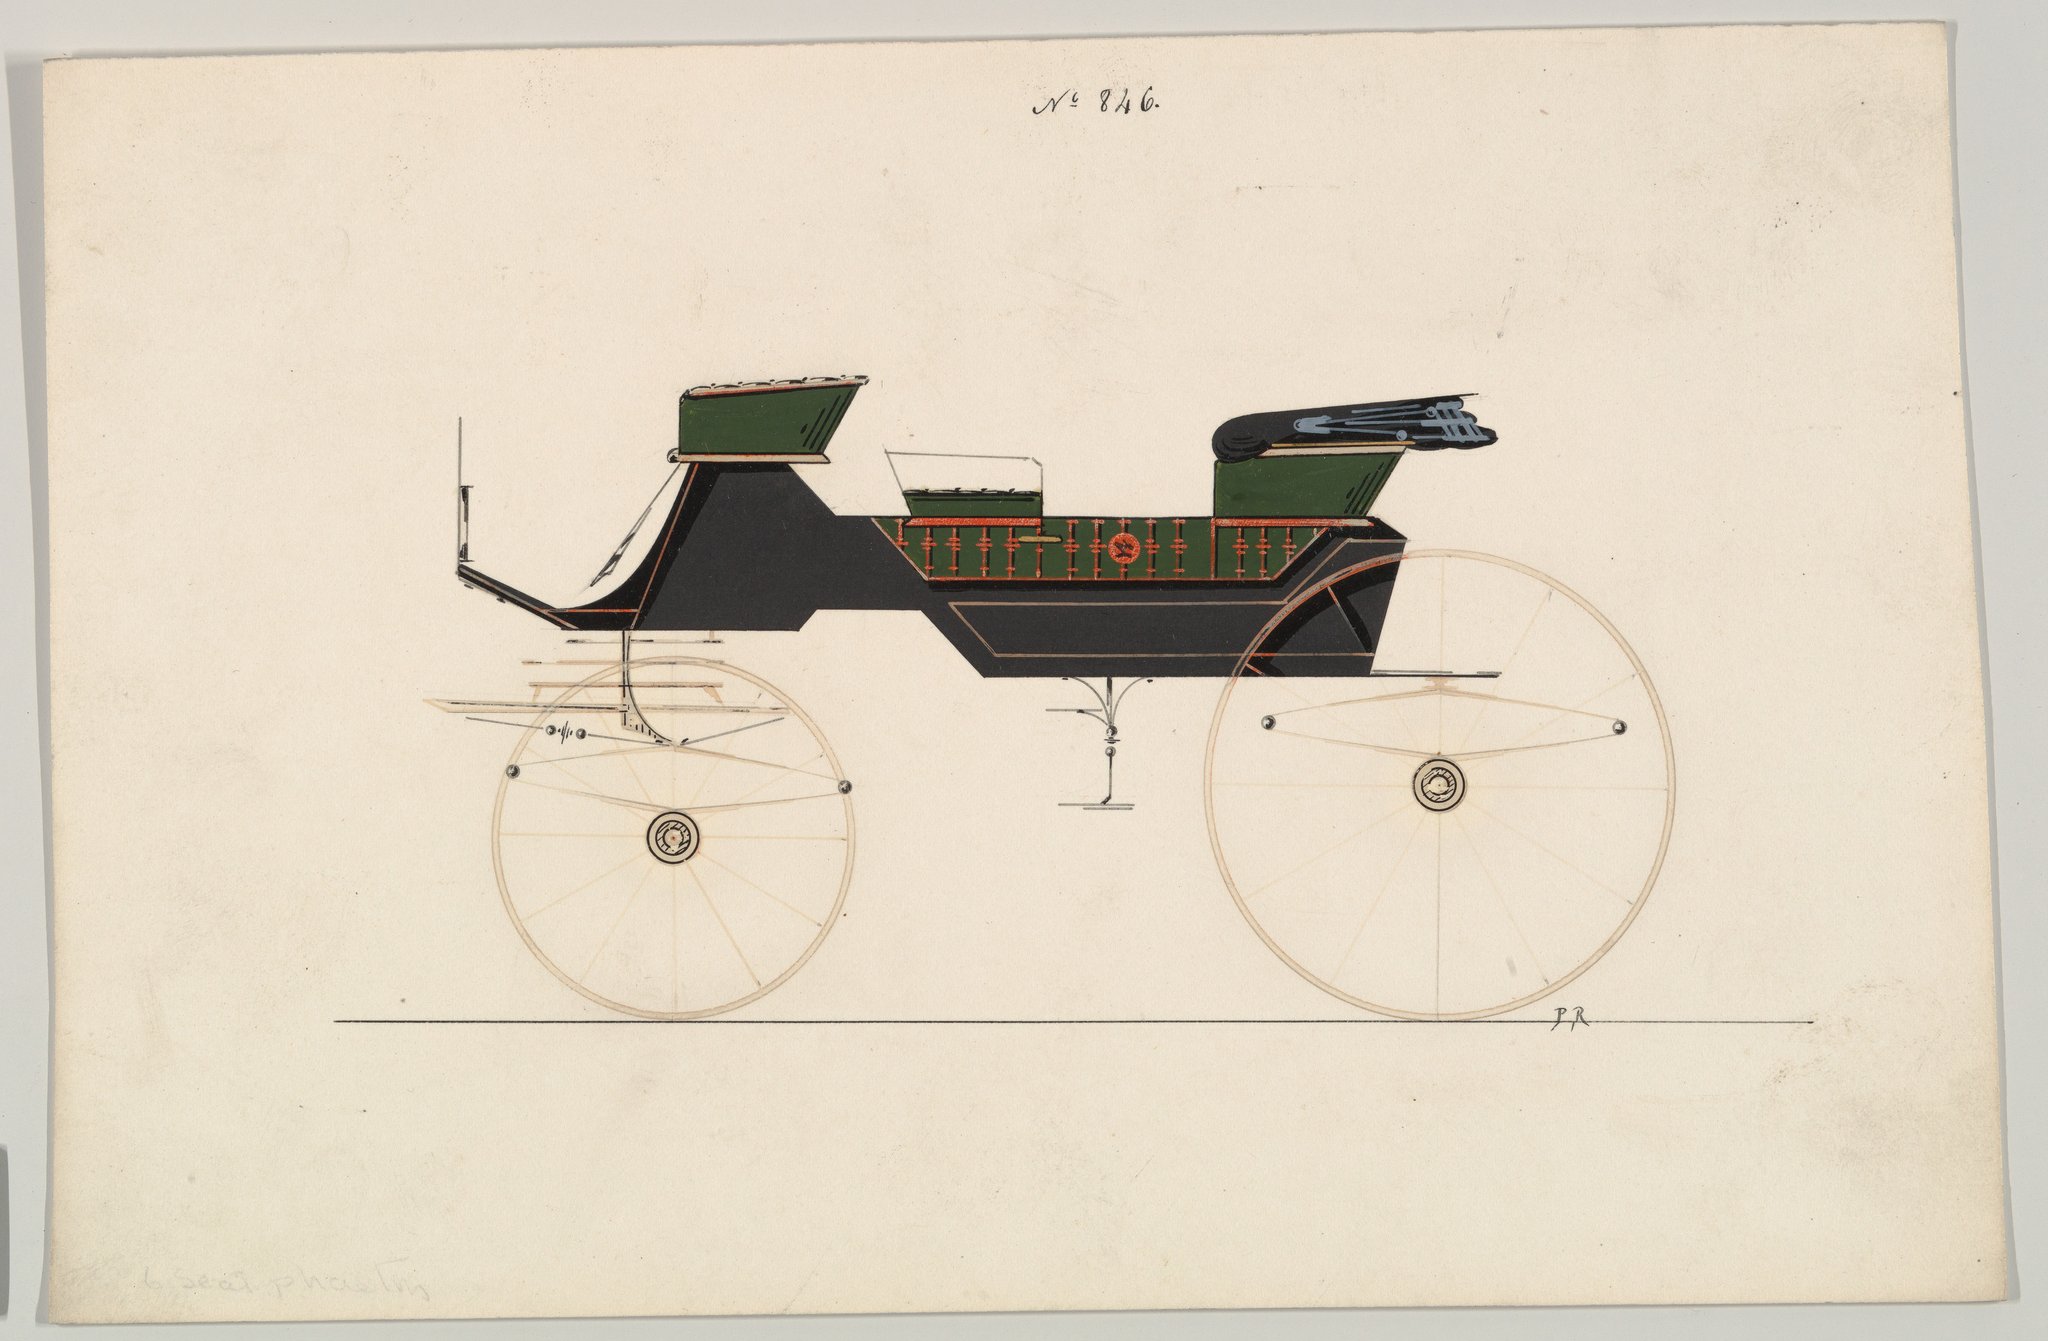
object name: drawing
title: Design for Vis-à-vis/ Charabanc, no. 846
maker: brewster & co.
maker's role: manufacturer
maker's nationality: american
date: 1870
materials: gouache, gum arabic, ink, watercolor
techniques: pen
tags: carriages